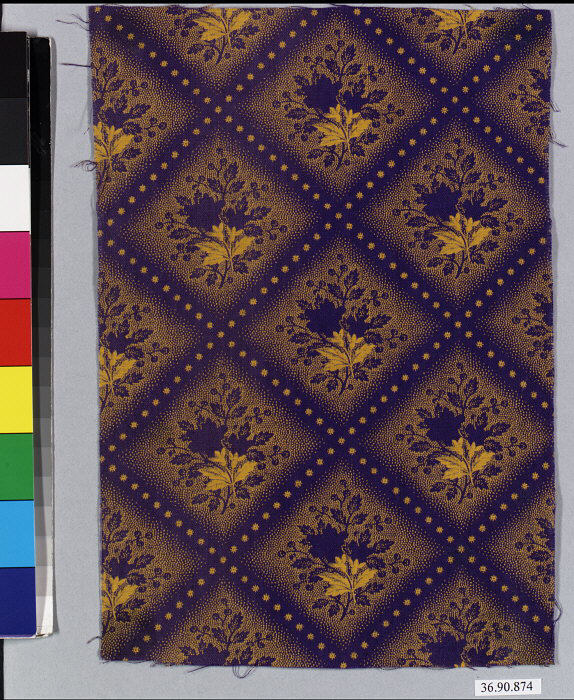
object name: piece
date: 1801-1900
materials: cotton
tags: leaves